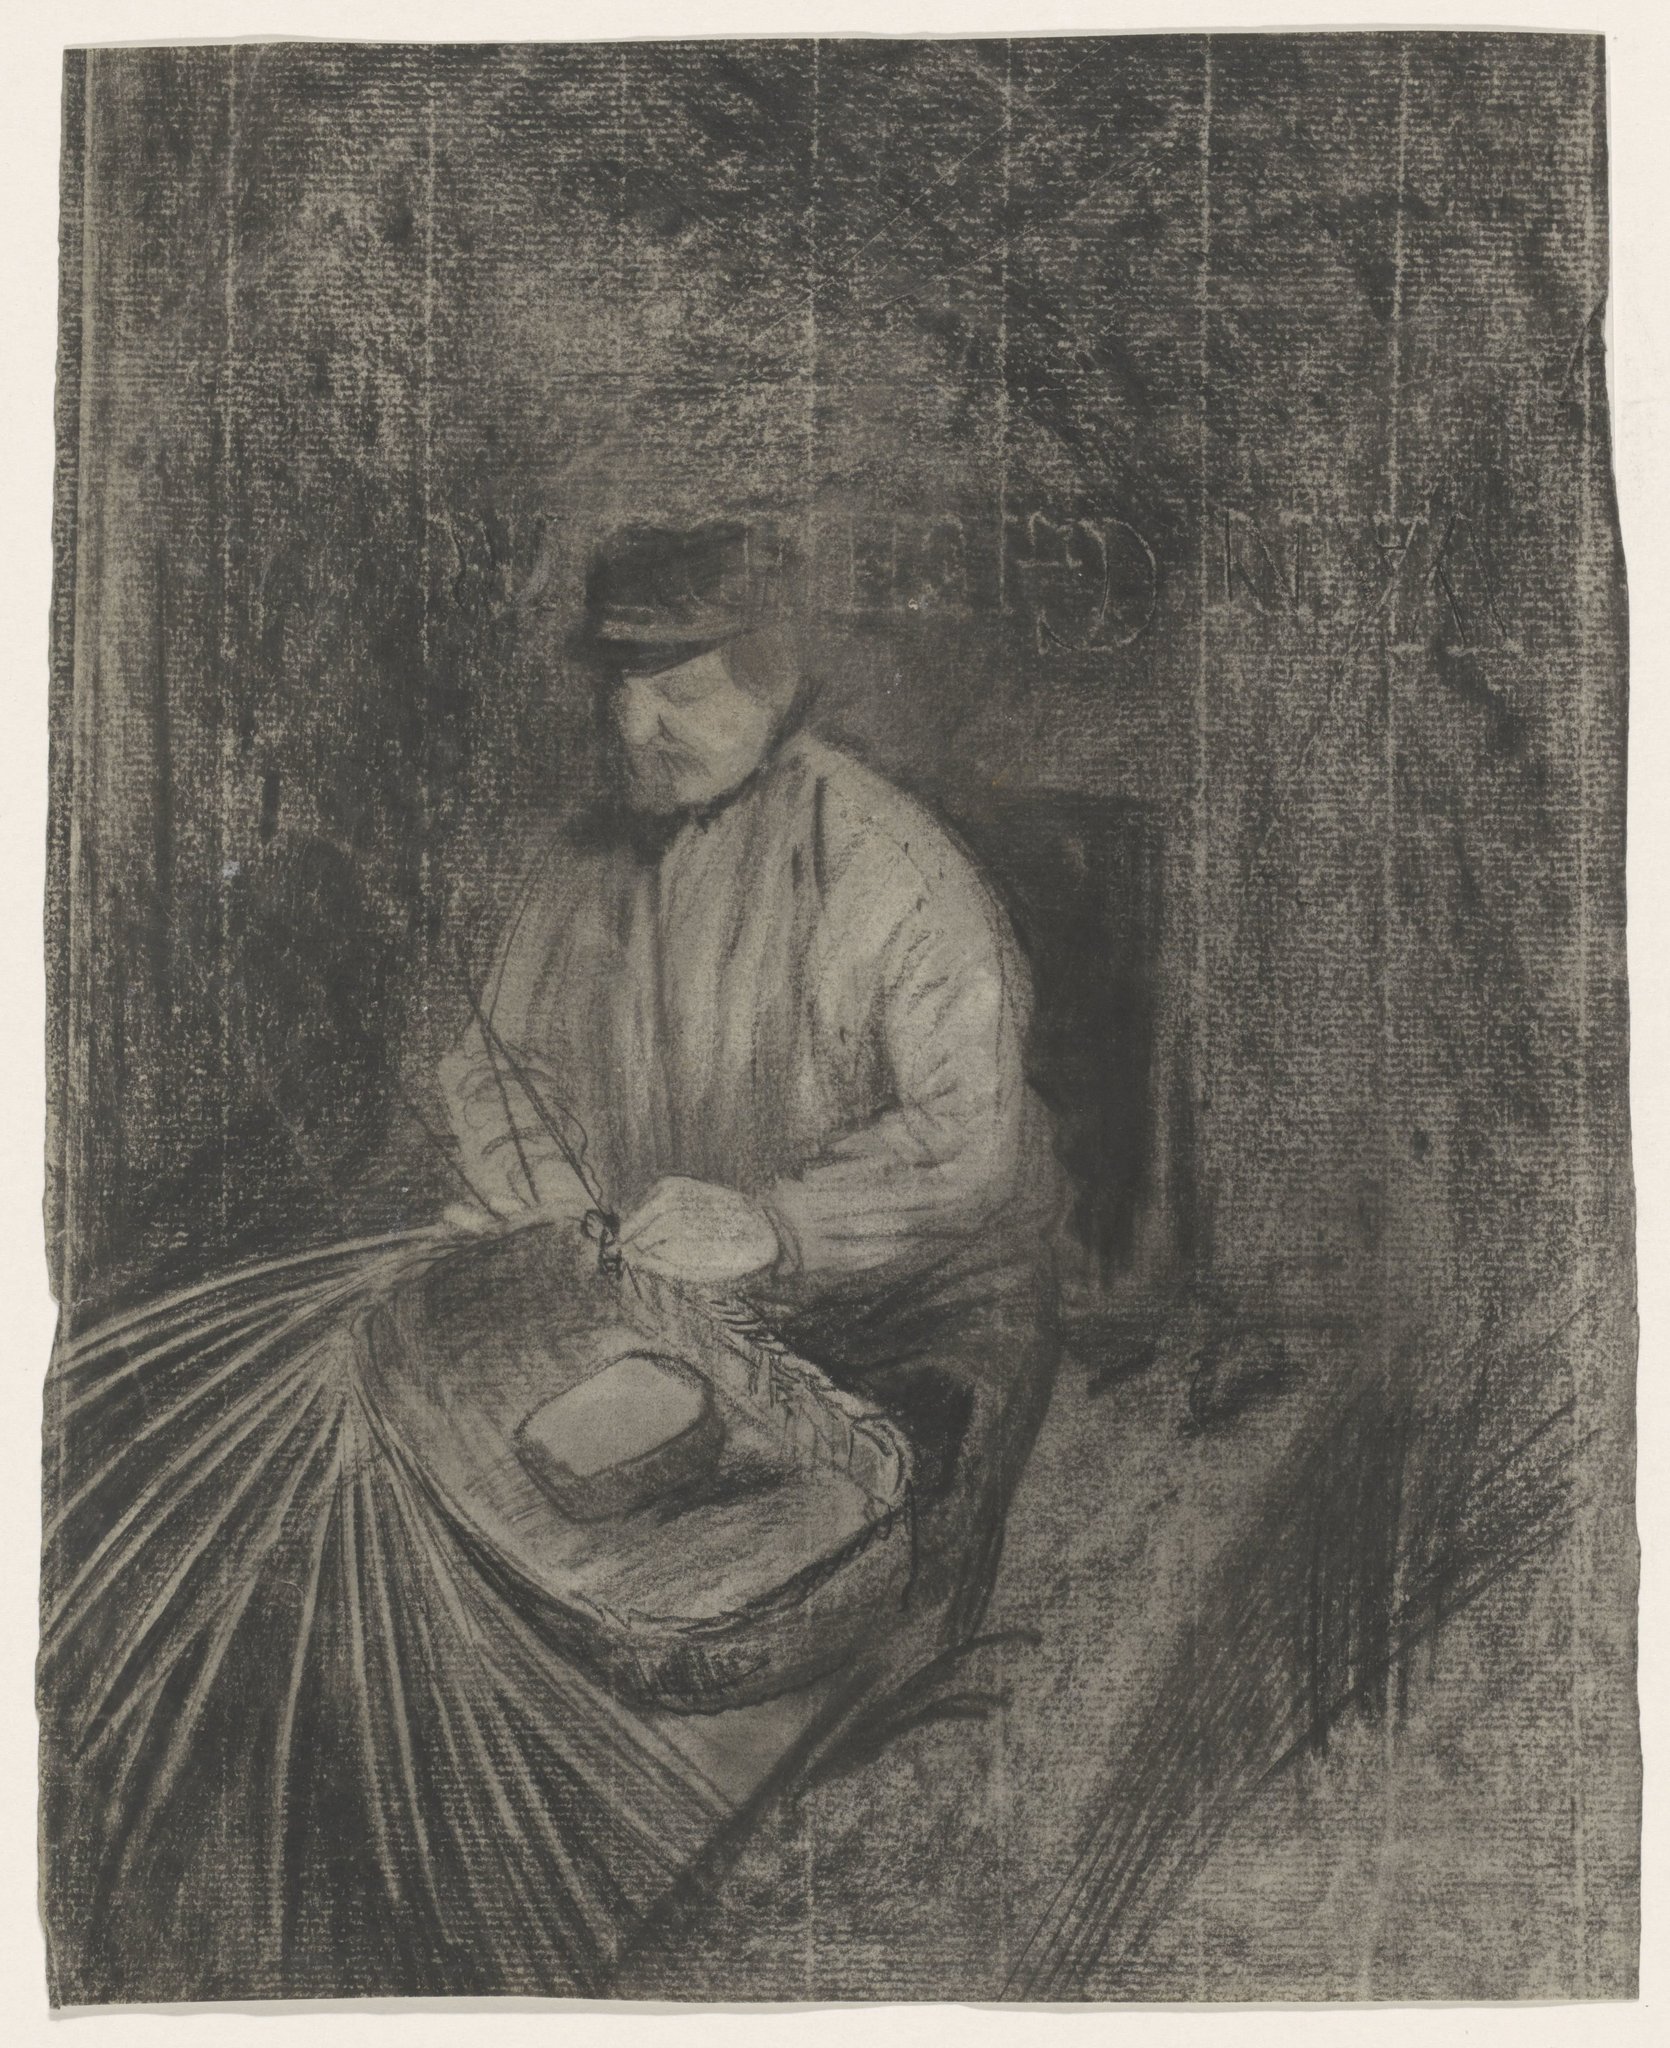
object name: drawing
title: Mandenmaker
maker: carel adolph lion cachet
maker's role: draughtsman, print maker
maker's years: 1864-1945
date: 1874-1945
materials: charcoal, paper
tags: handicrafts ~ other plant material, container made of plant material other than wood: basket